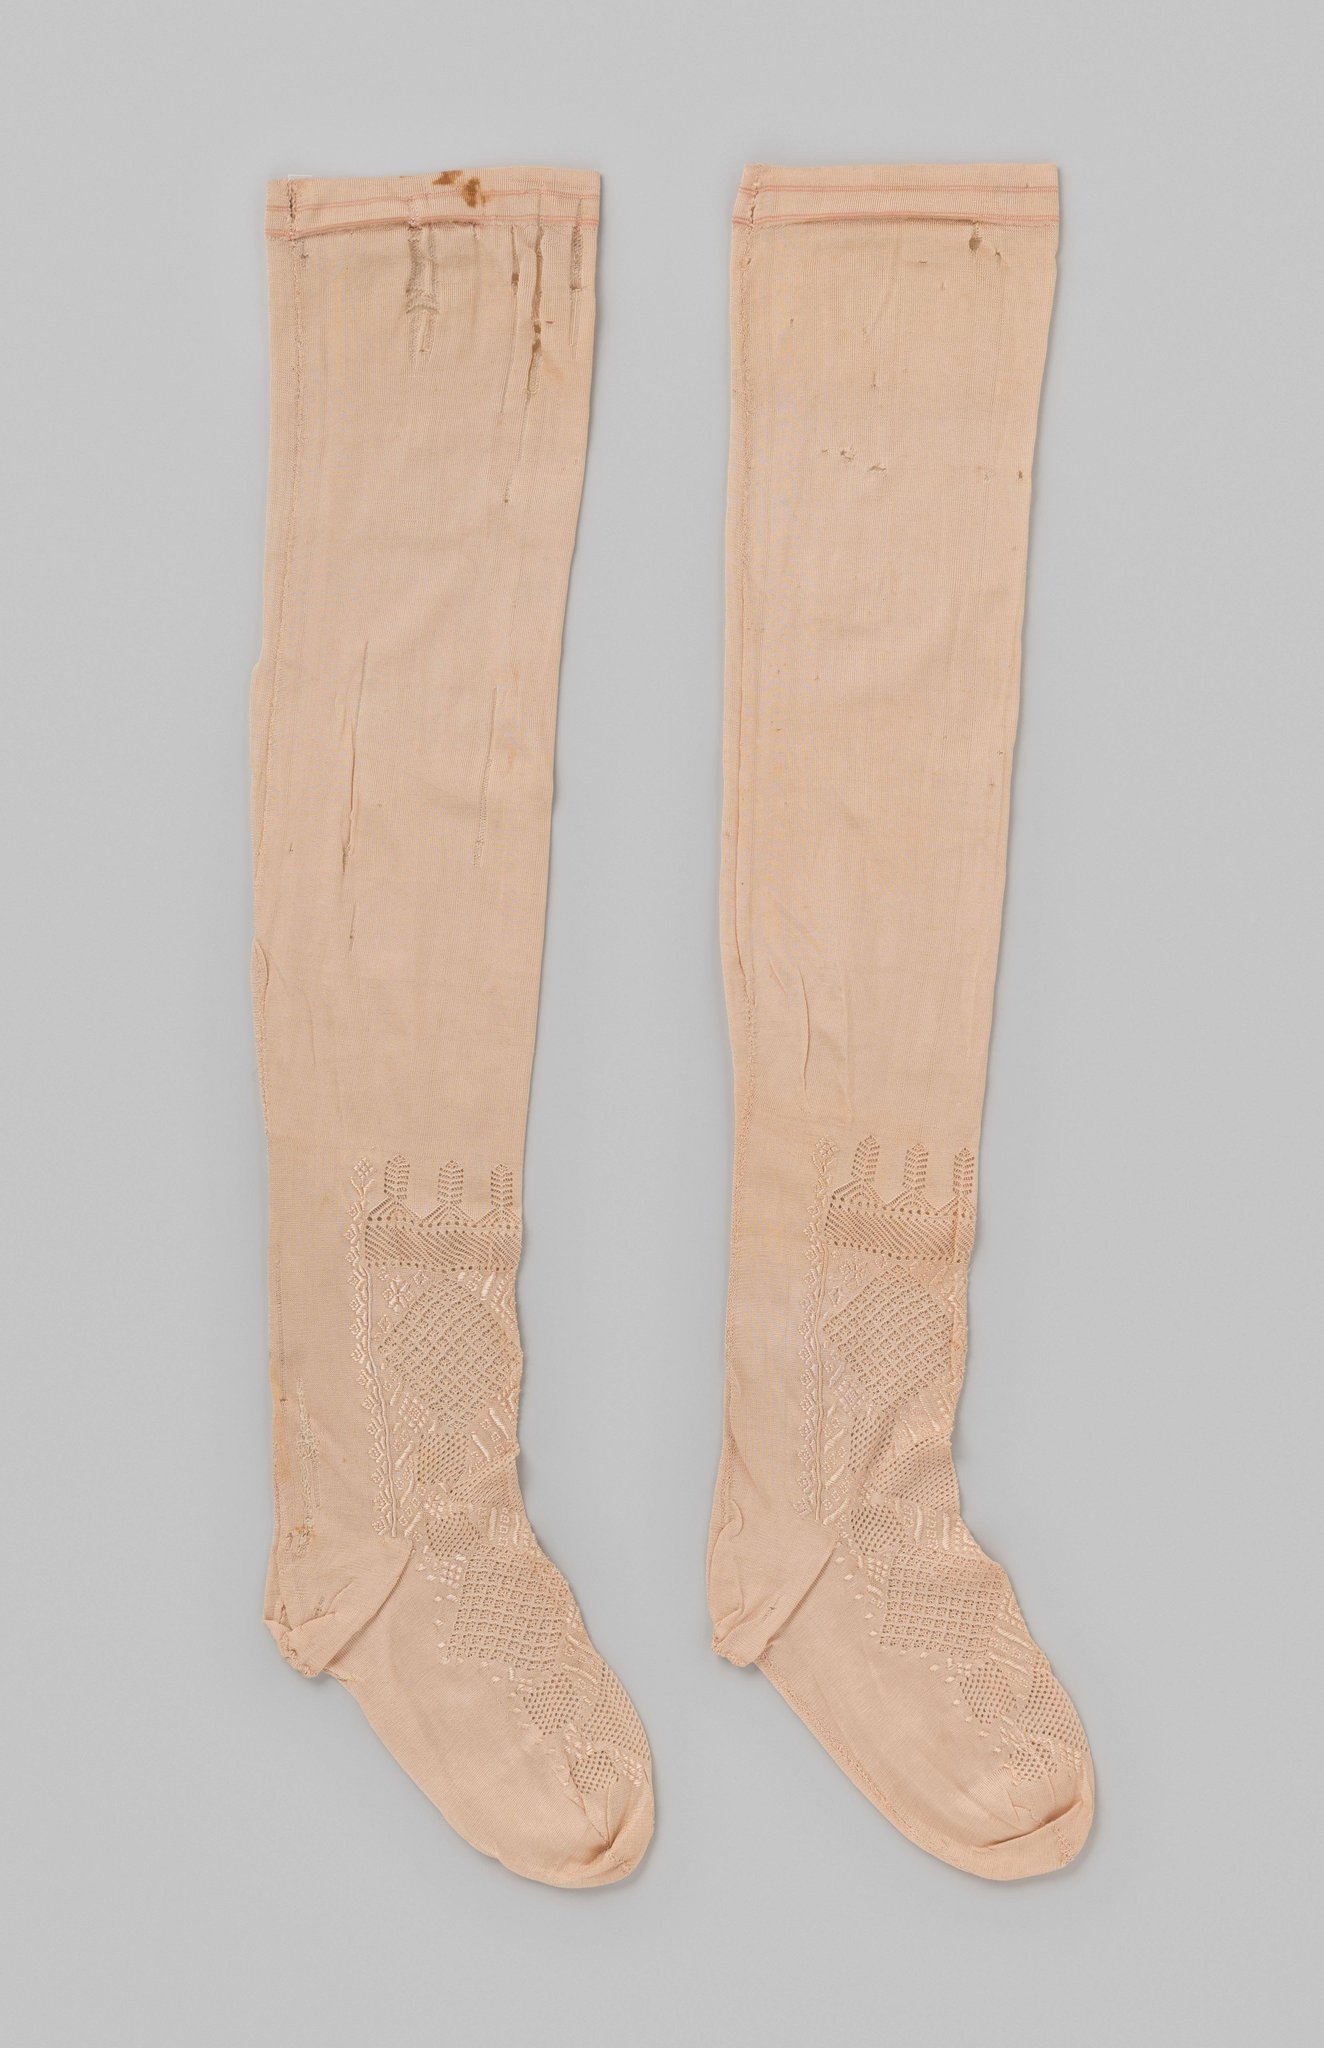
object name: stocking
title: Kous van lichtrose zijde, met ajour- en borduurwerk op klink en wreef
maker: Anonymous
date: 1900-1910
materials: silk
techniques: embroidery, embroidered, knitting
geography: paris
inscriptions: inscription: ‘.M.S. (of C.M.S.)/ anker/ 1834’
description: Paar kousen van lichtrose zijde, ajourwerk. Opengewerkte siersteek, 'pattes', op de wreef en tot enkelhoogte. Groot rasterwerk, gevuld met ruiten met fijner rasterwerk in twee patronen. Opschrift: (gestempeld op het boord): G.M.S. (of C.M.S.)/ anker/ 1834 in rechthoekig kader.